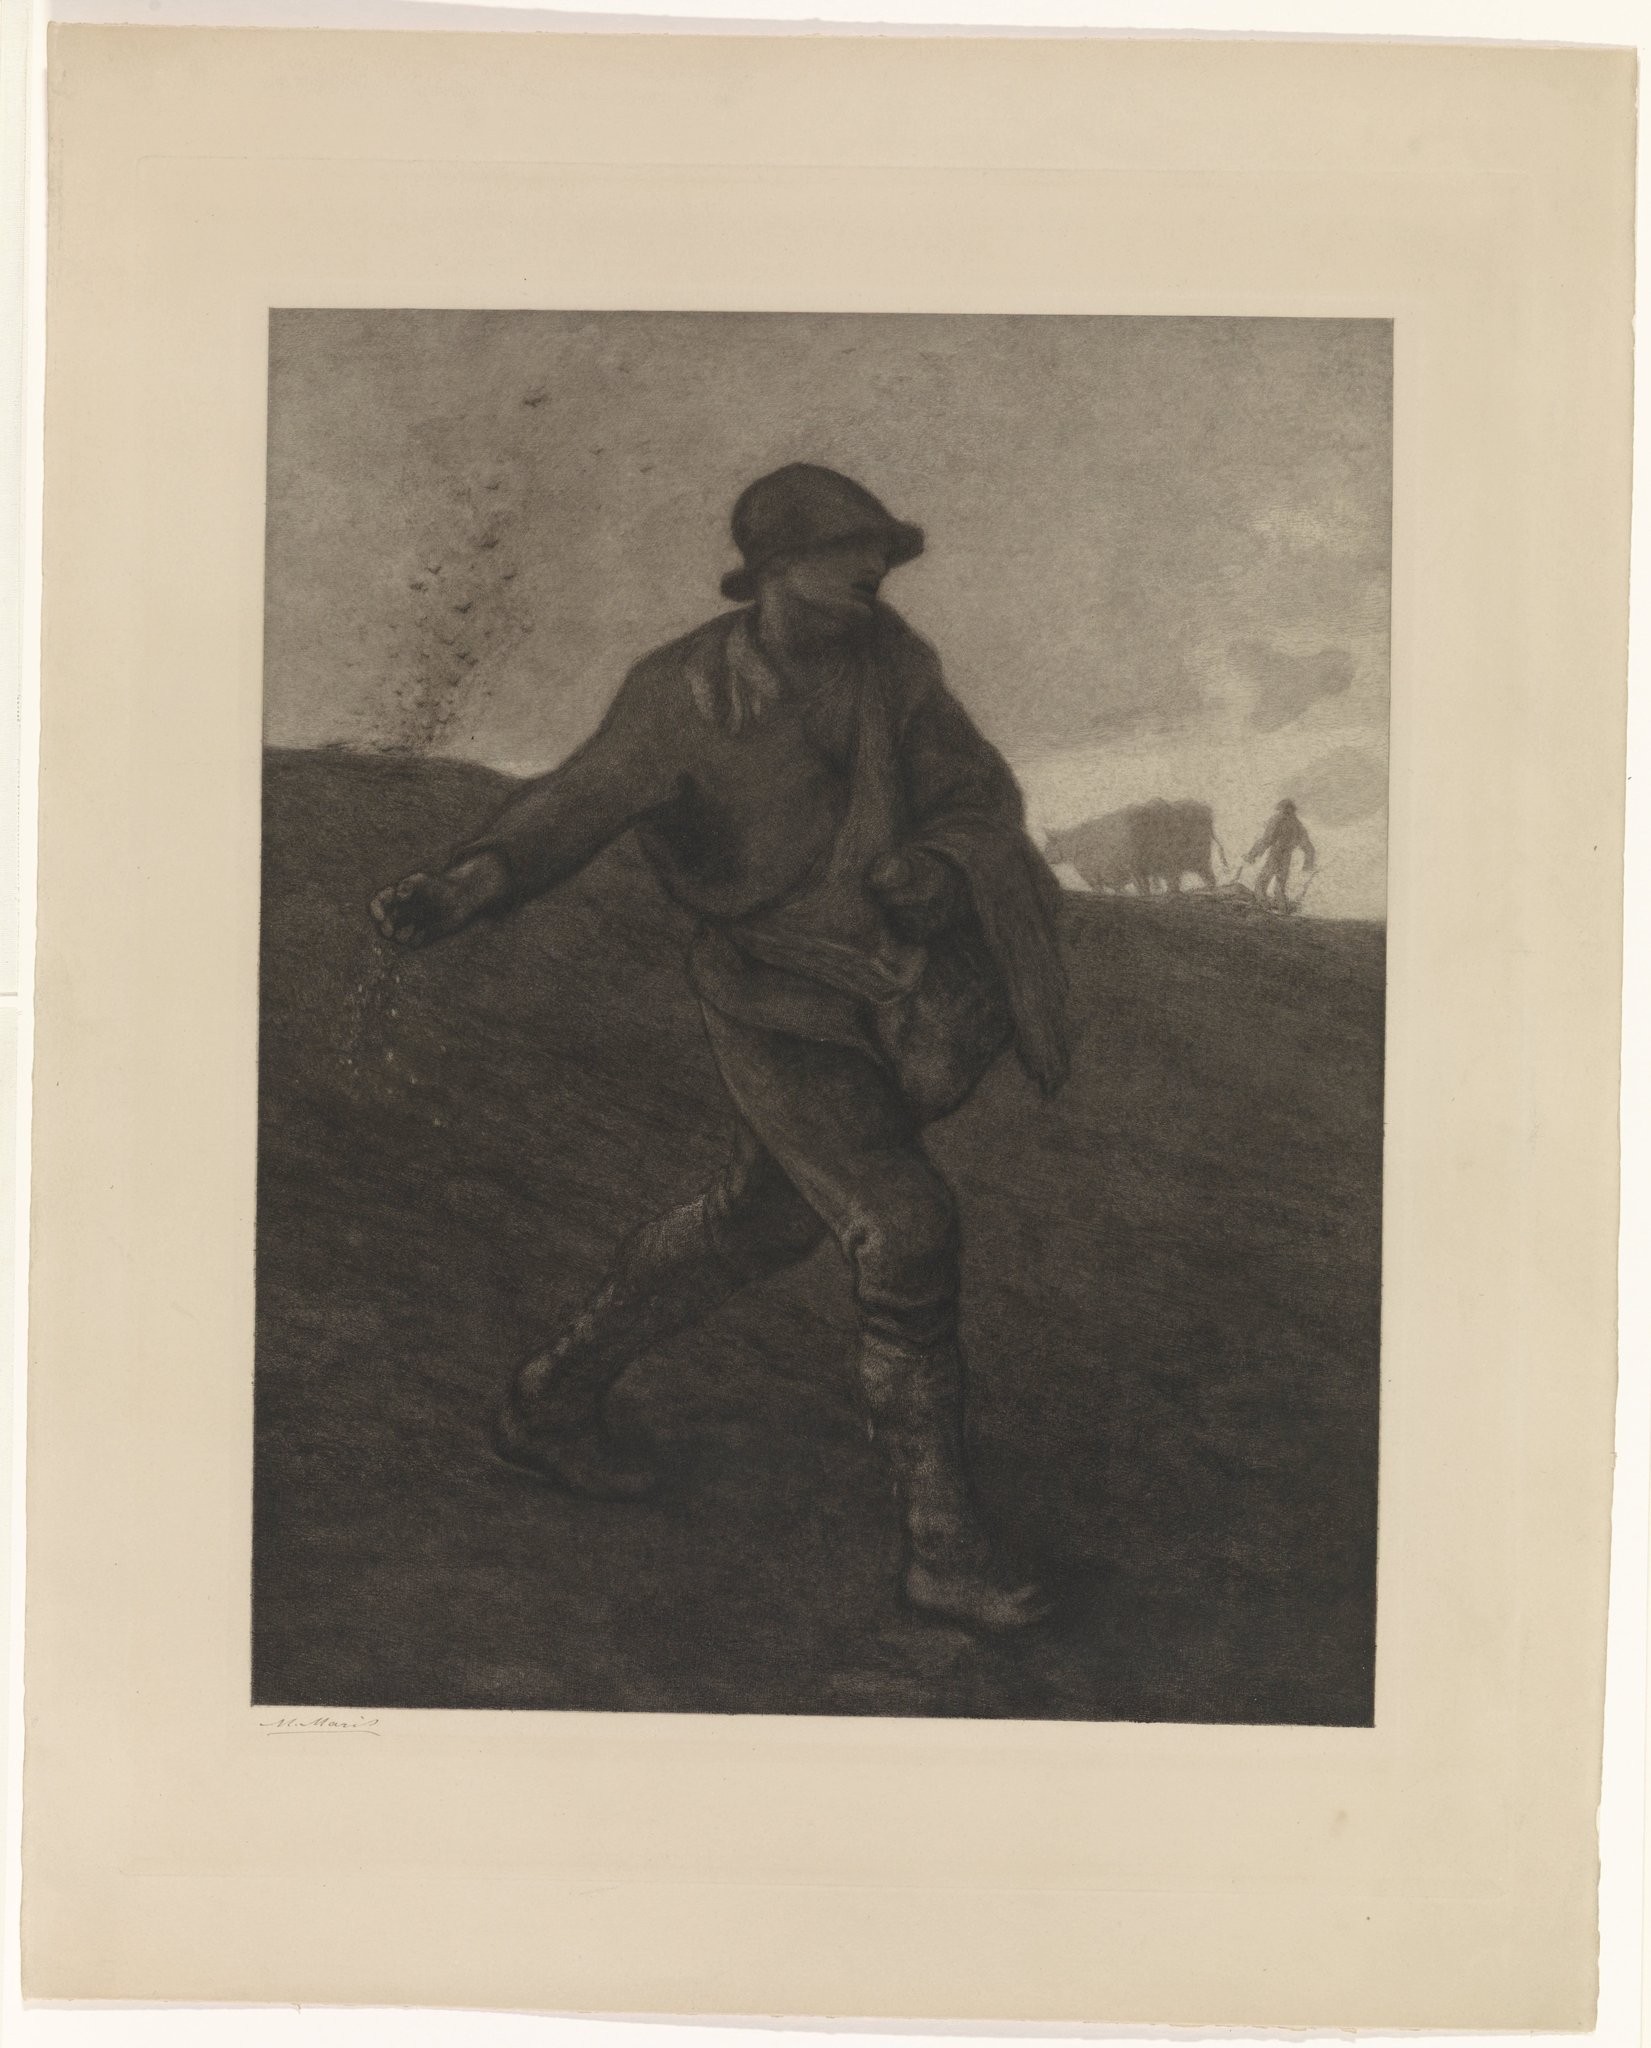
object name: print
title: The Sower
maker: matthijs maris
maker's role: draughtsman, painter, print maker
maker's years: 1839-1917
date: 1881-1882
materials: paper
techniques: drypoint, etching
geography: london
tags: sowing